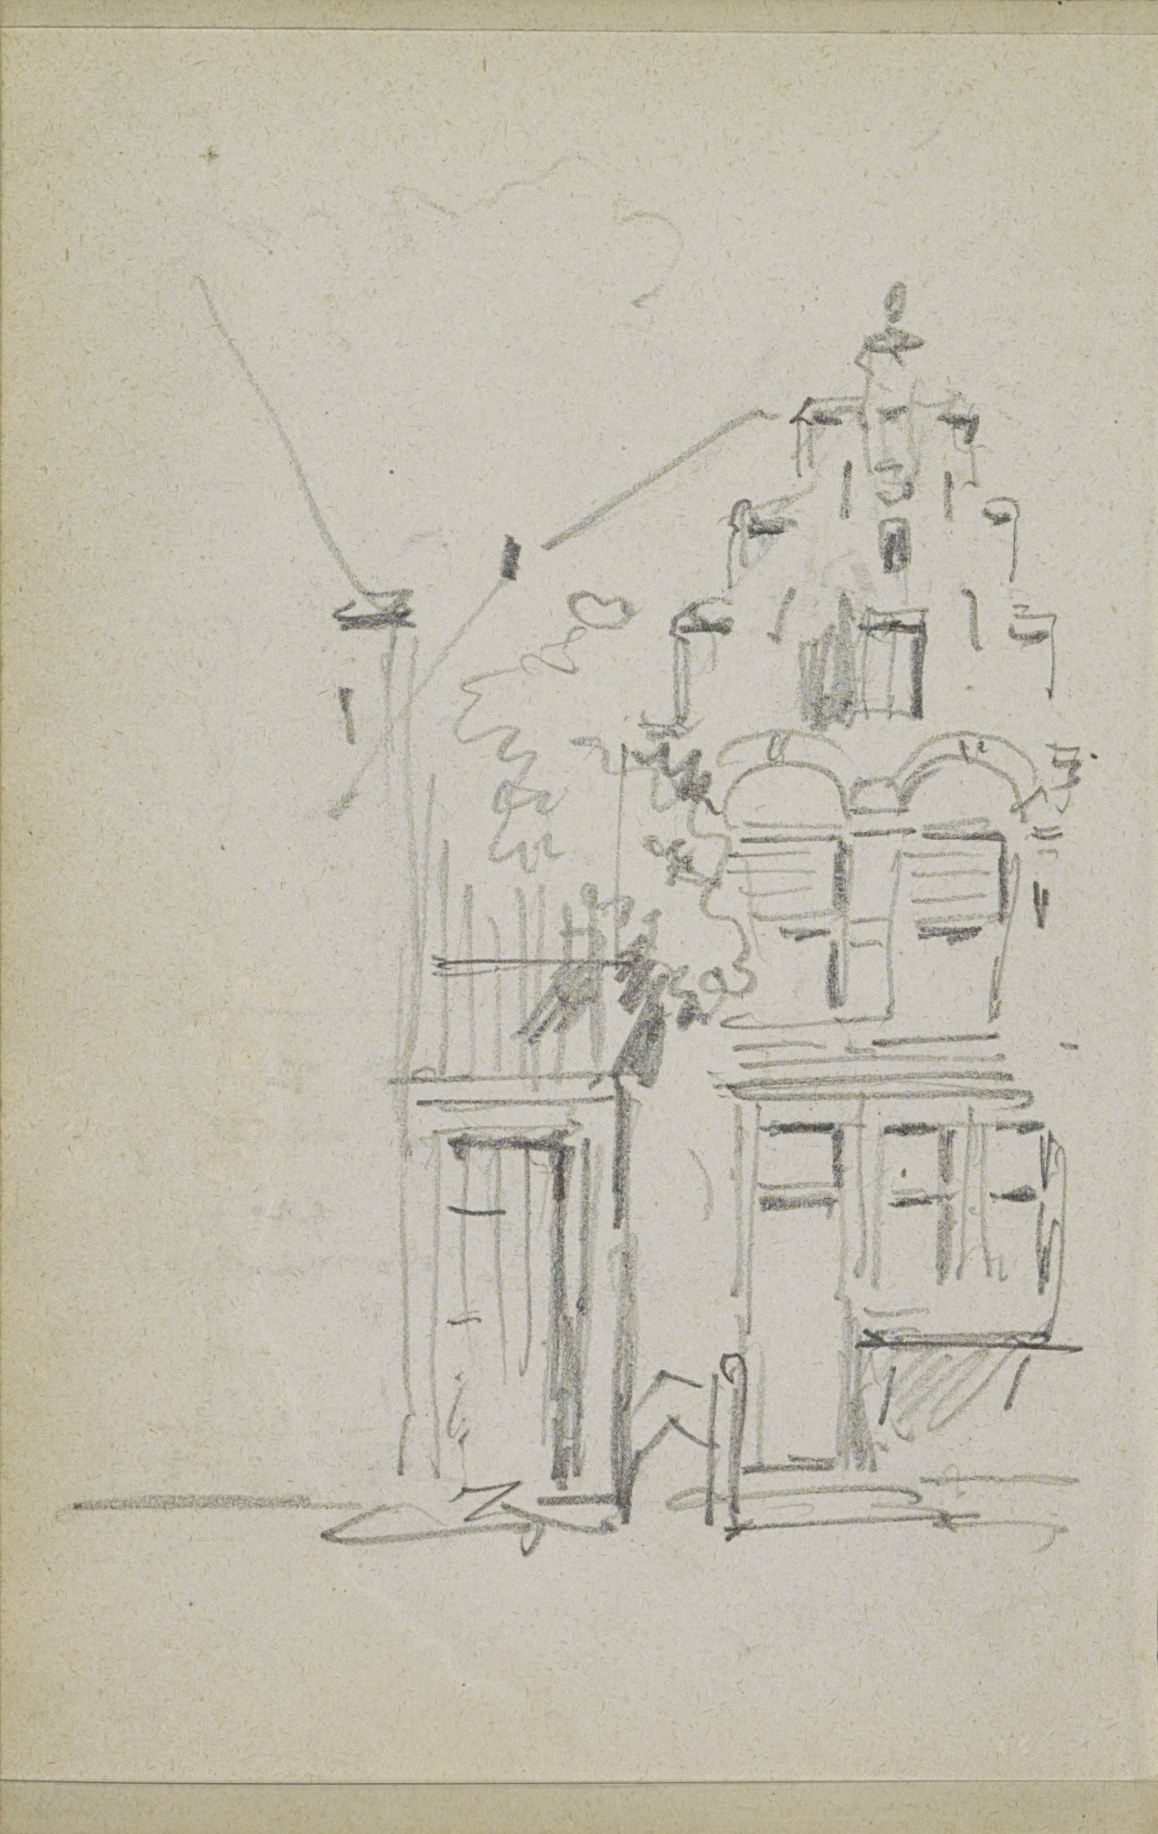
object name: sketchbook leaf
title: Gezicht op een gebouw met een trapgevel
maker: adrianus eversen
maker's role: draughtsman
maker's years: 1818-1897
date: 1828-1897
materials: paper, pencil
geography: netherlands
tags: decorated gable, façade (of house or building)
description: Gezicht op een gebouw met een trapgevel. Blad 22 verso uit een schetsboek met 58 bladen.